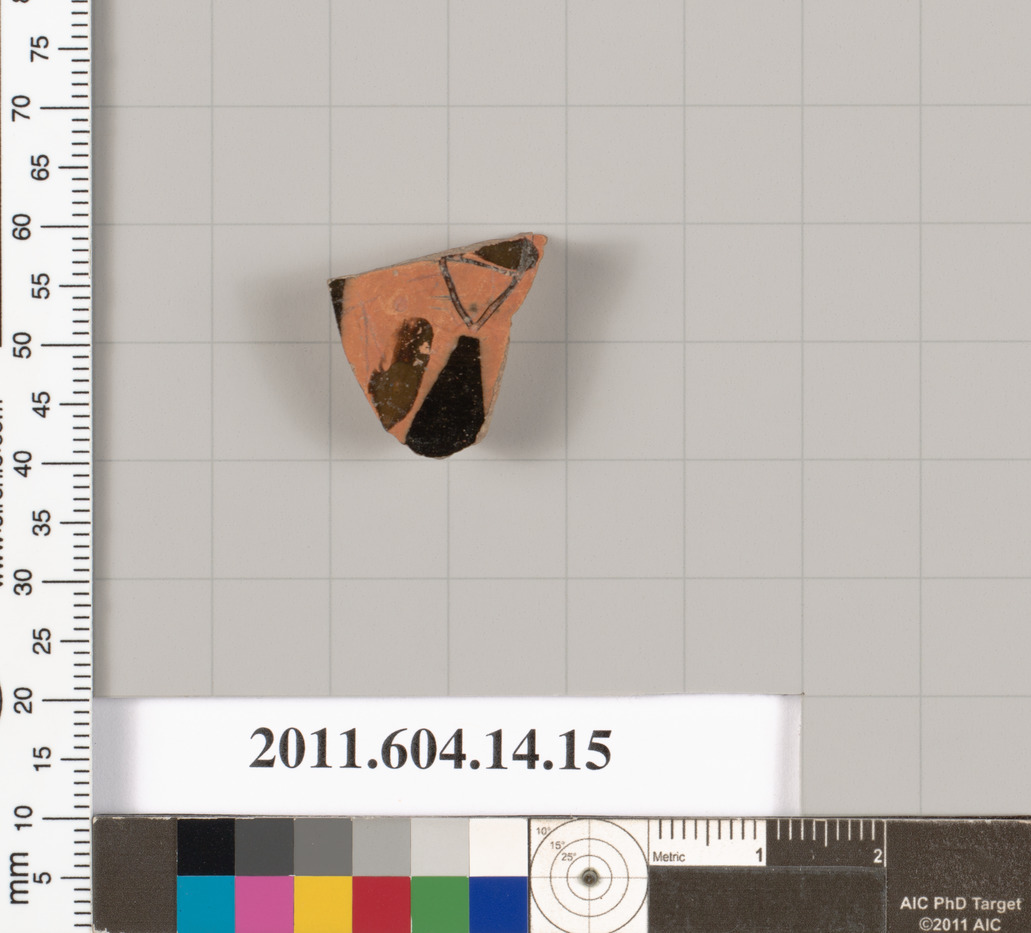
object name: undetermined closed shape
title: Terracotta fragment of an undetermined closed shape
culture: unknown fabric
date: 600-501 BCE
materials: terracotta